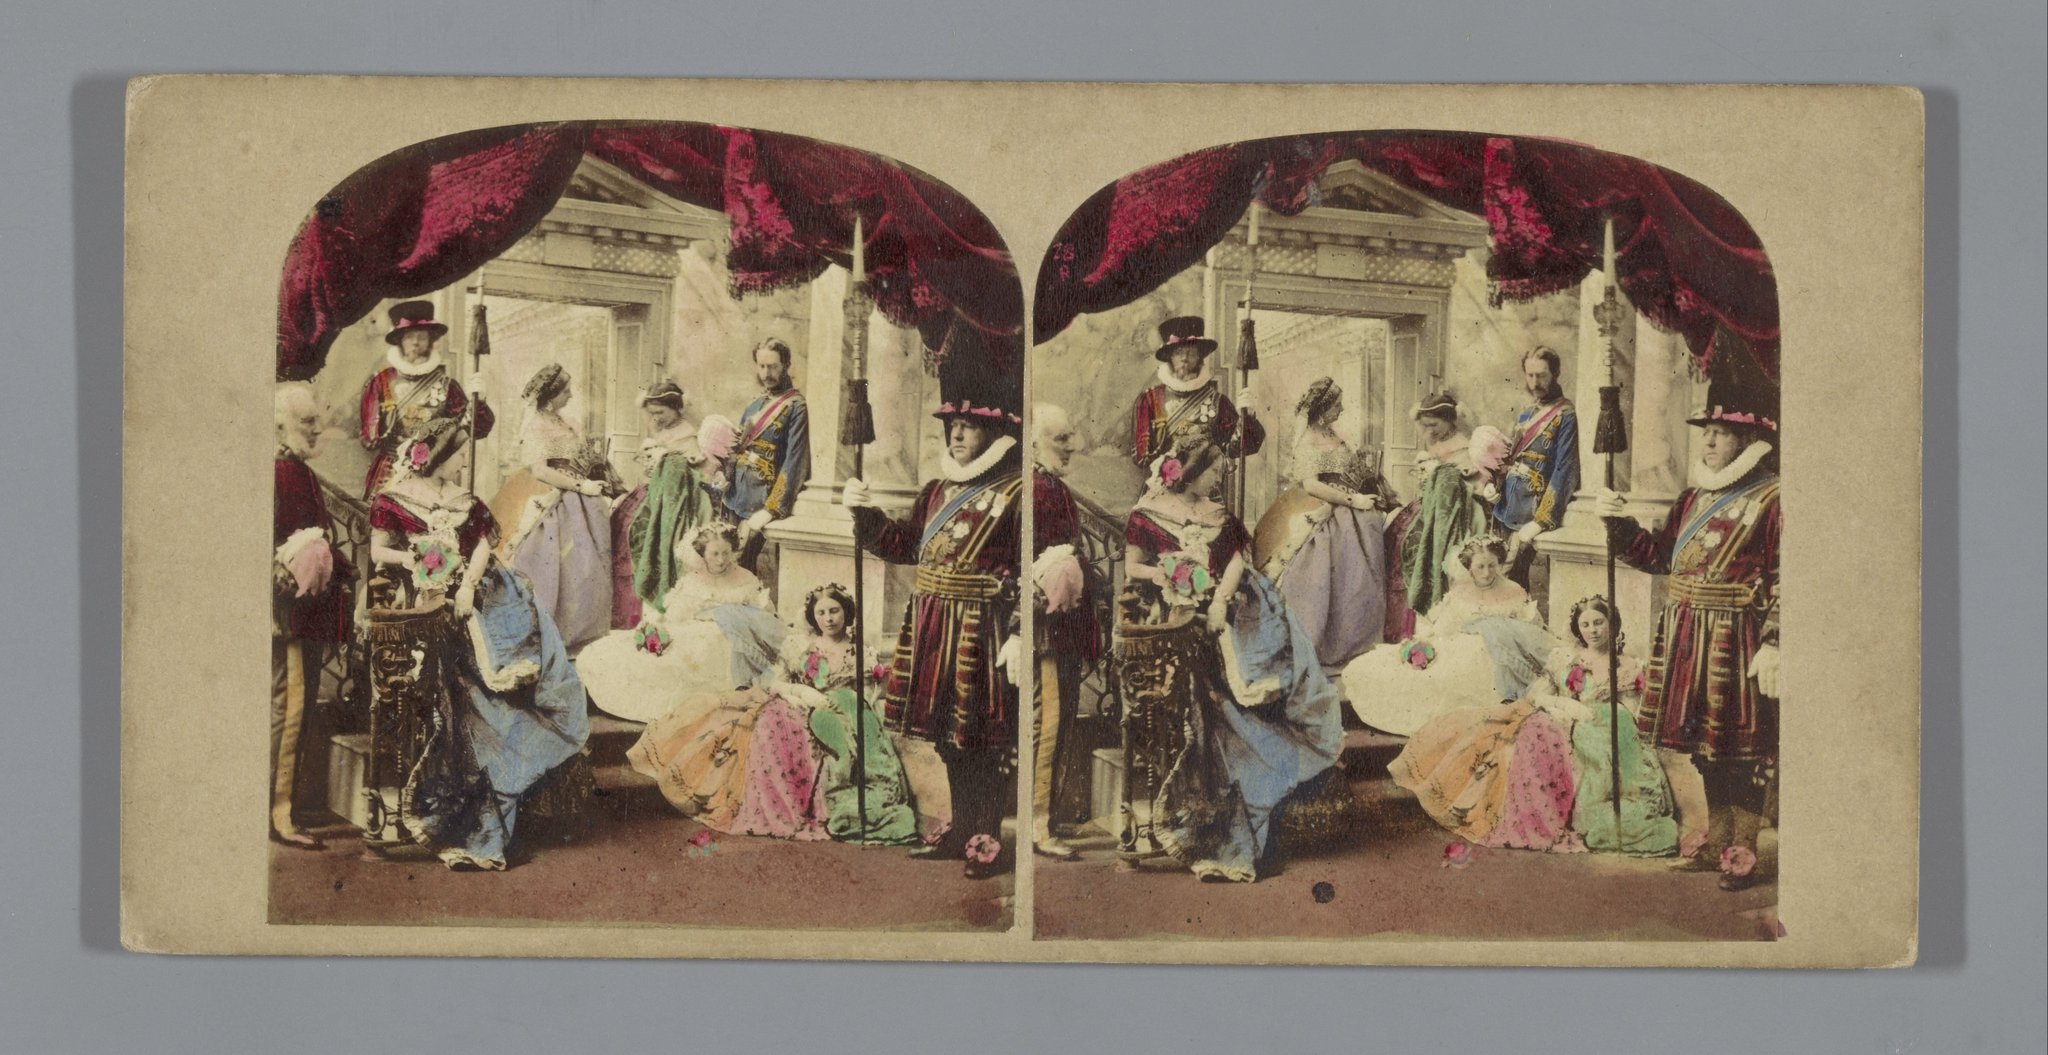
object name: stereograph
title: Drawing-Room Day. The Staircase at St. James's Palace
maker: james elliott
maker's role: publisher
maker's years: 1832-1900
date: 1856-1861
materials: cardboard, paper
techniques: albumen print, hand coloring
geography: st james's palace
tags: royal household; courtiers, retinue, train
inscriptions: inscription: ‘A.L.’